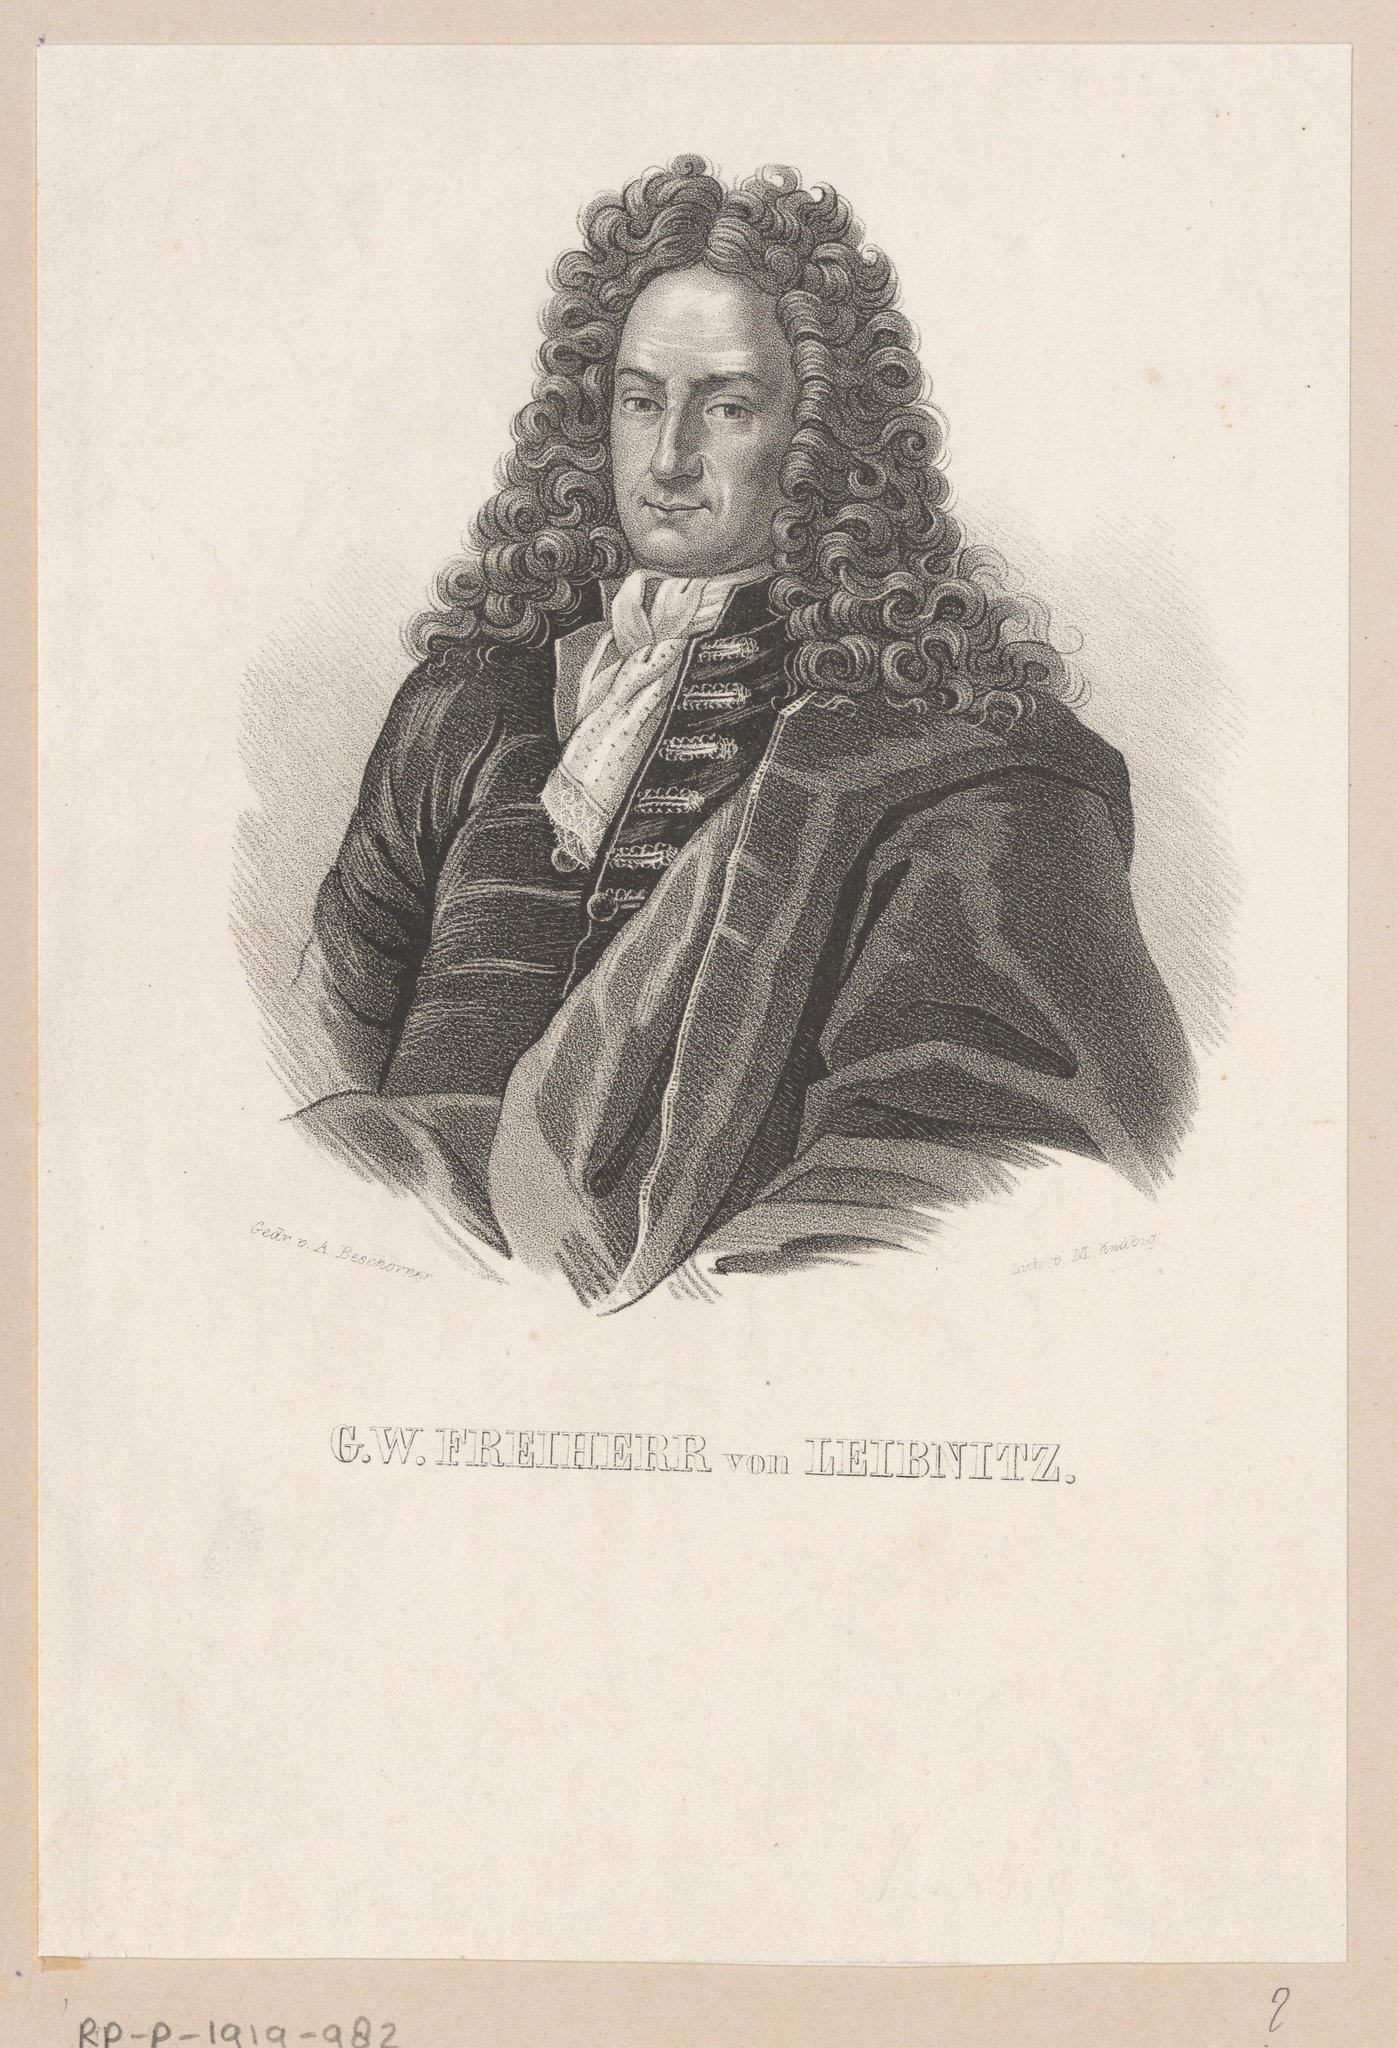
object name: print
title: Portret van Gottfried Wilhelm Leibniz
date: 1814-1876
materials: paper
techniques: lithograph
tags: historical persons, scholar, philosopher (+ portrait of scholar, scientist)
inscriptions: collector's mark: Lugt 2228